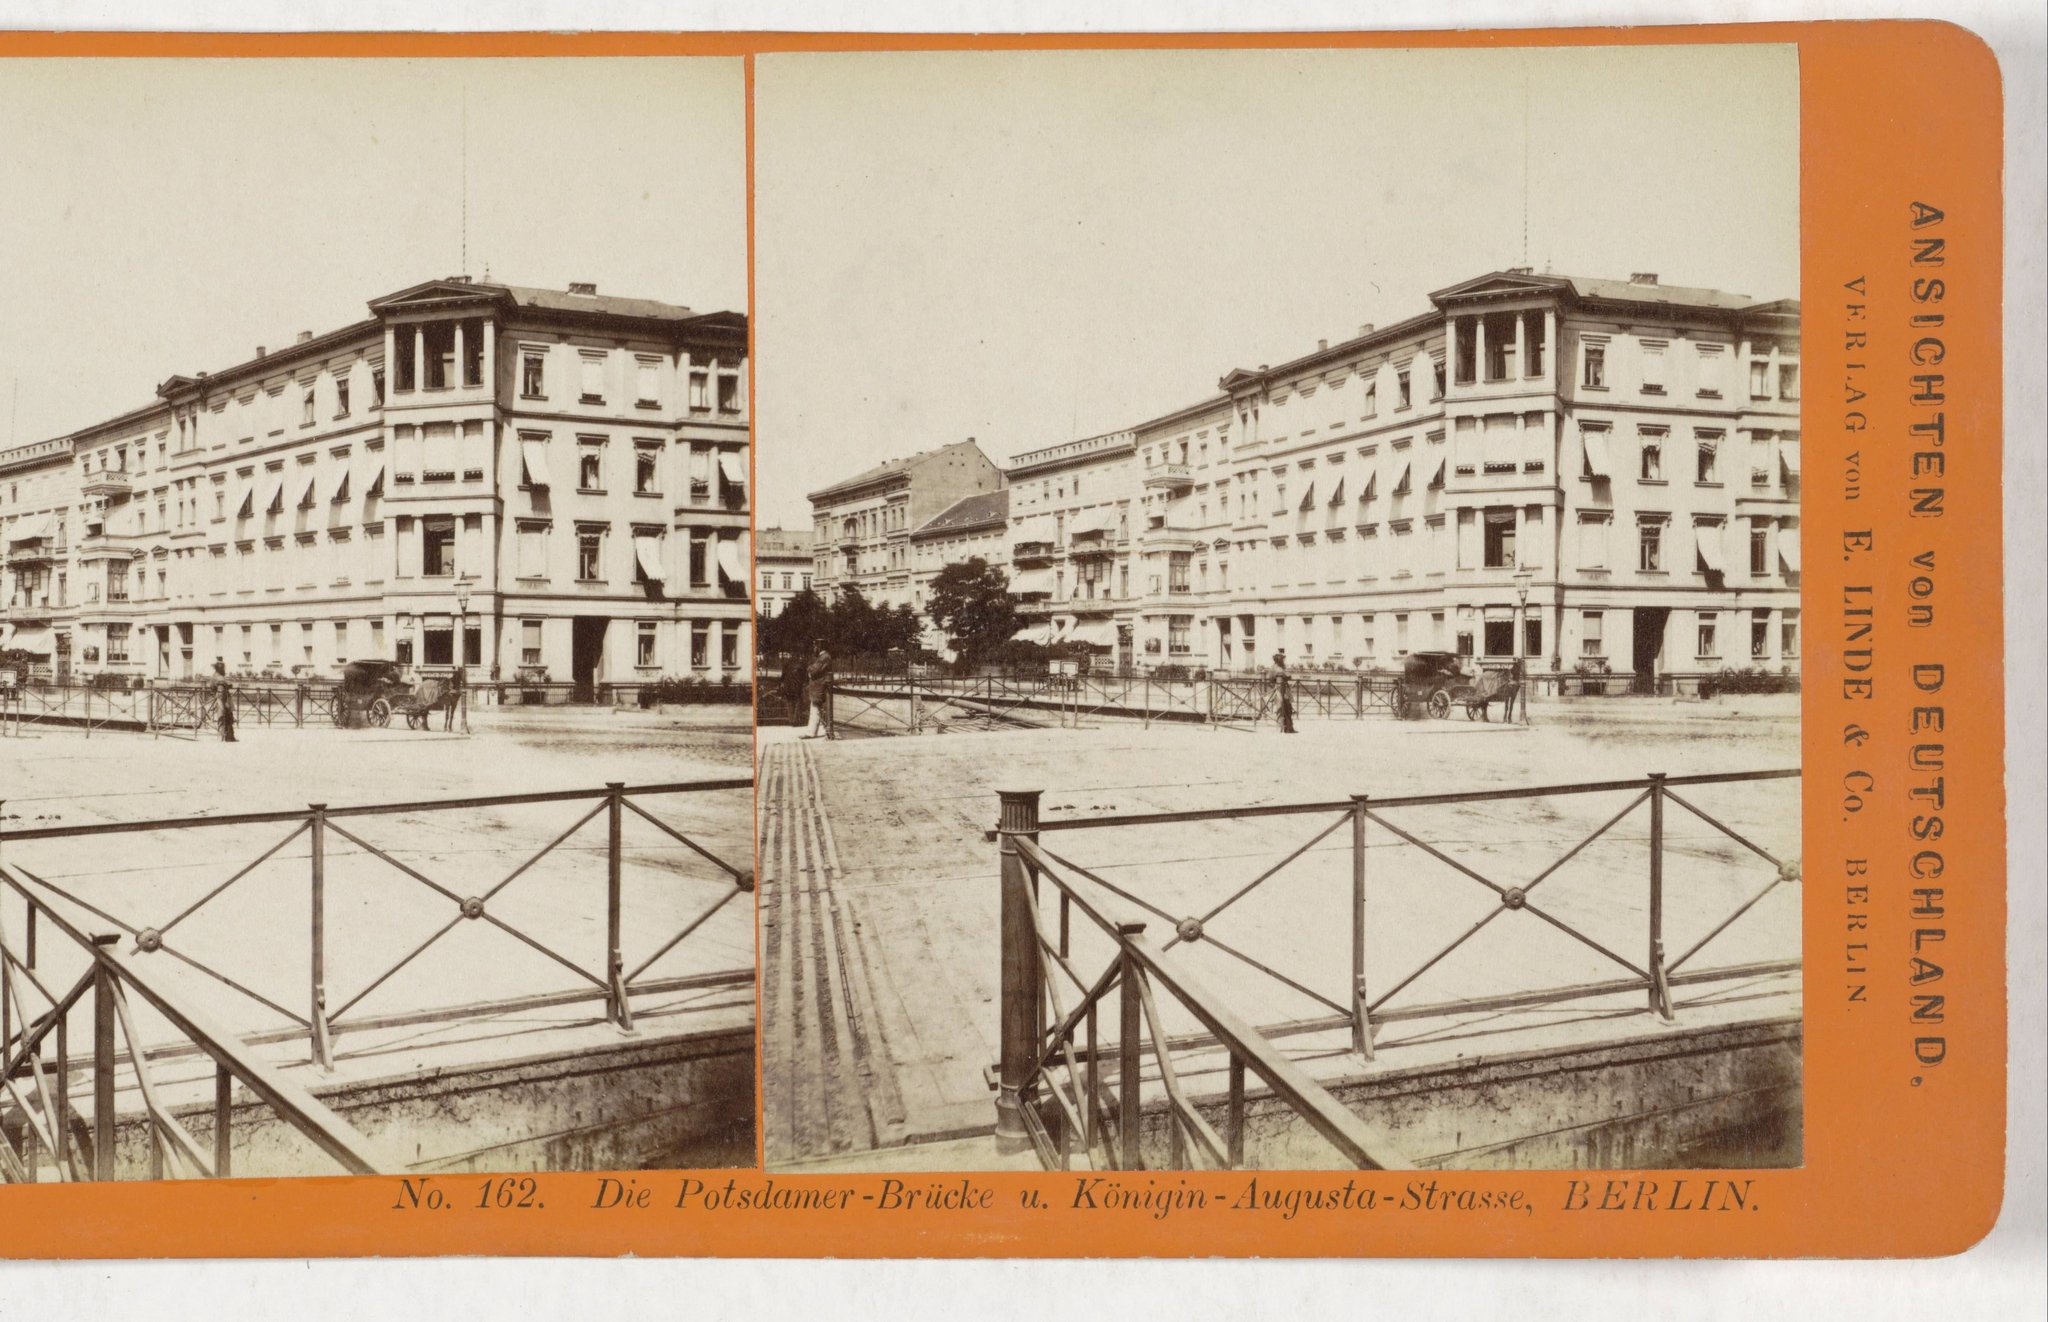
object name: stereograph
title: Die Potsdamer-Brücke u. Königin-Augusta-Strasse, Berlin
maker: johann friedrich stiehm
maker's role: fotograaf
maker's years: 1826-1902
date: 1868-1870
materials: cardboard, paper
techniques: albumen print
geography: berlin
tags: bridge in city across river, canal, etc., berlin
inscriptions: number: ‘No. 162.’